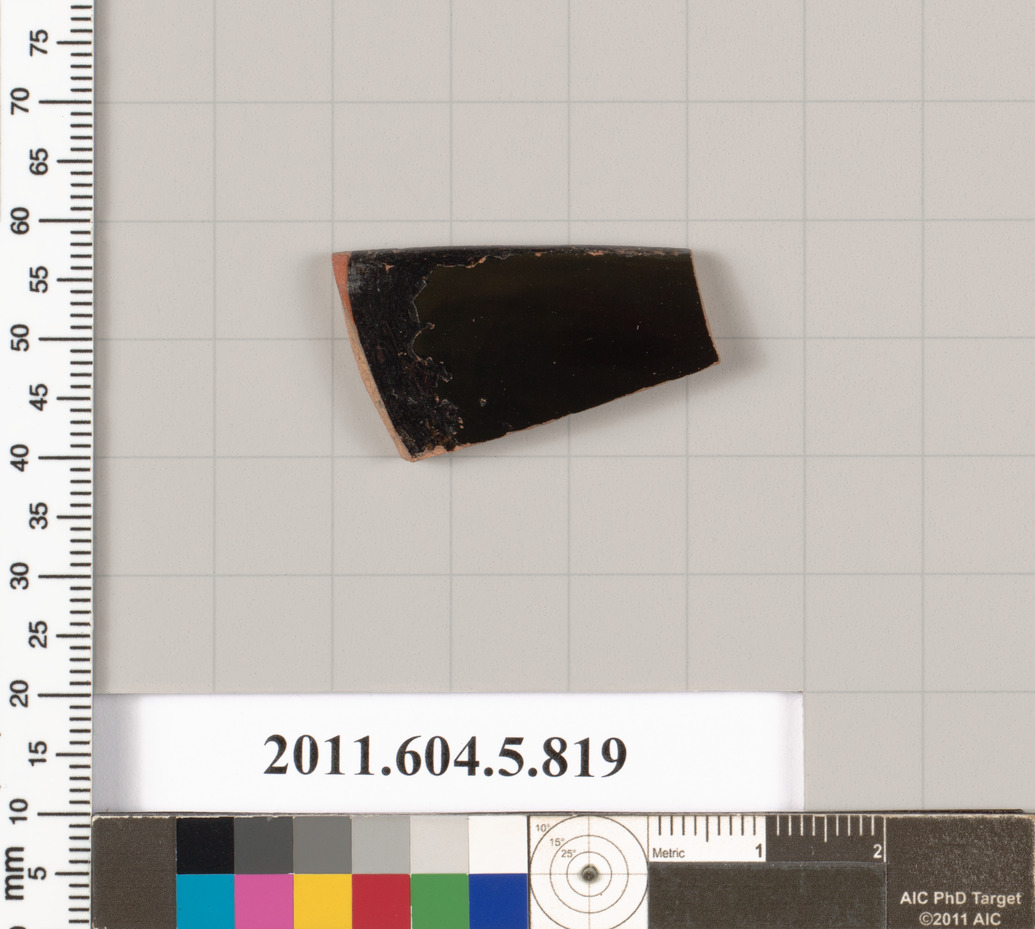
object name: kylix fragment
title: Terracotta fragments of kylikes (drinking cups)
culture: greek, attic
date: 600-401 BCE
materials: terracotta